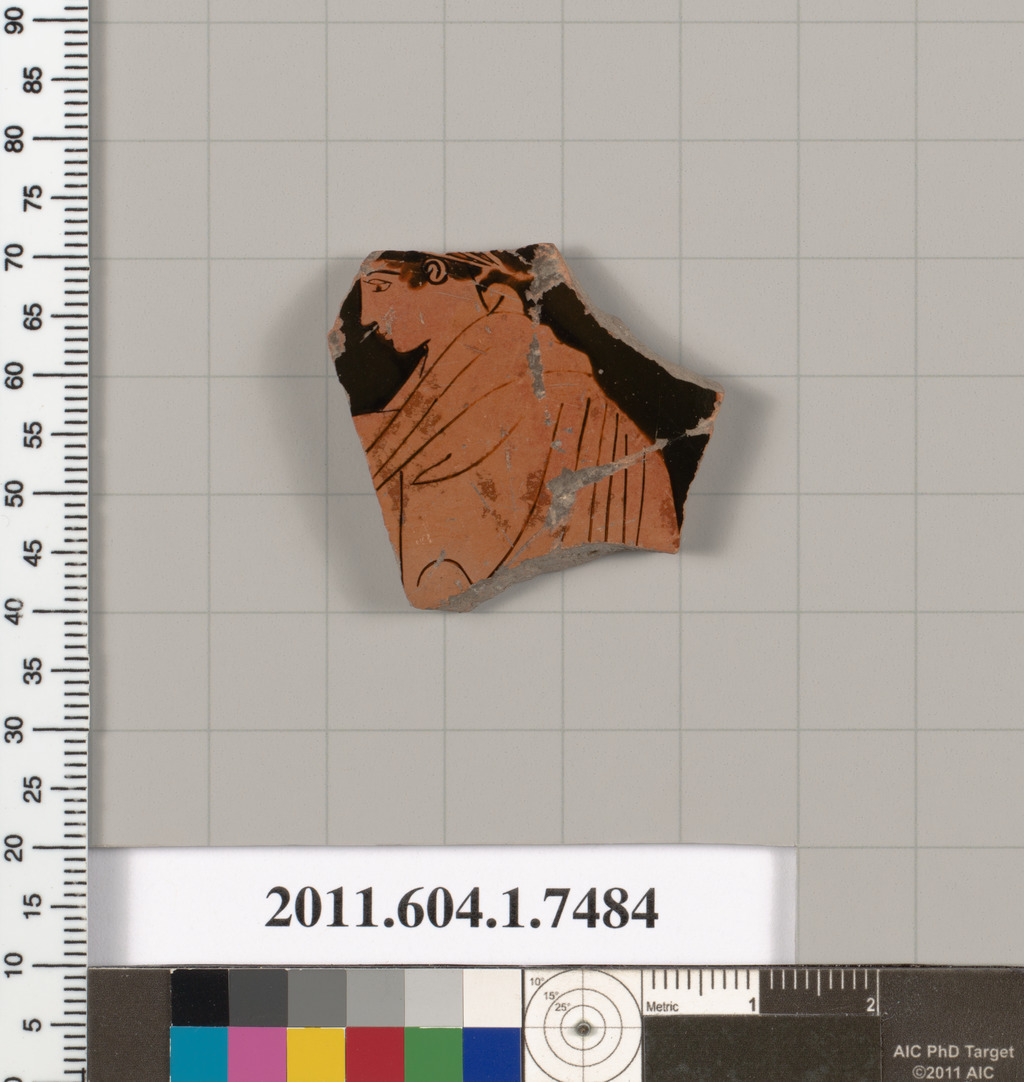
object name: kylix fragment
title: Terracotta fragment of a kylix (drinking cup)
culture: greek, attic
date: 460-450 BCE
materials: terracotta